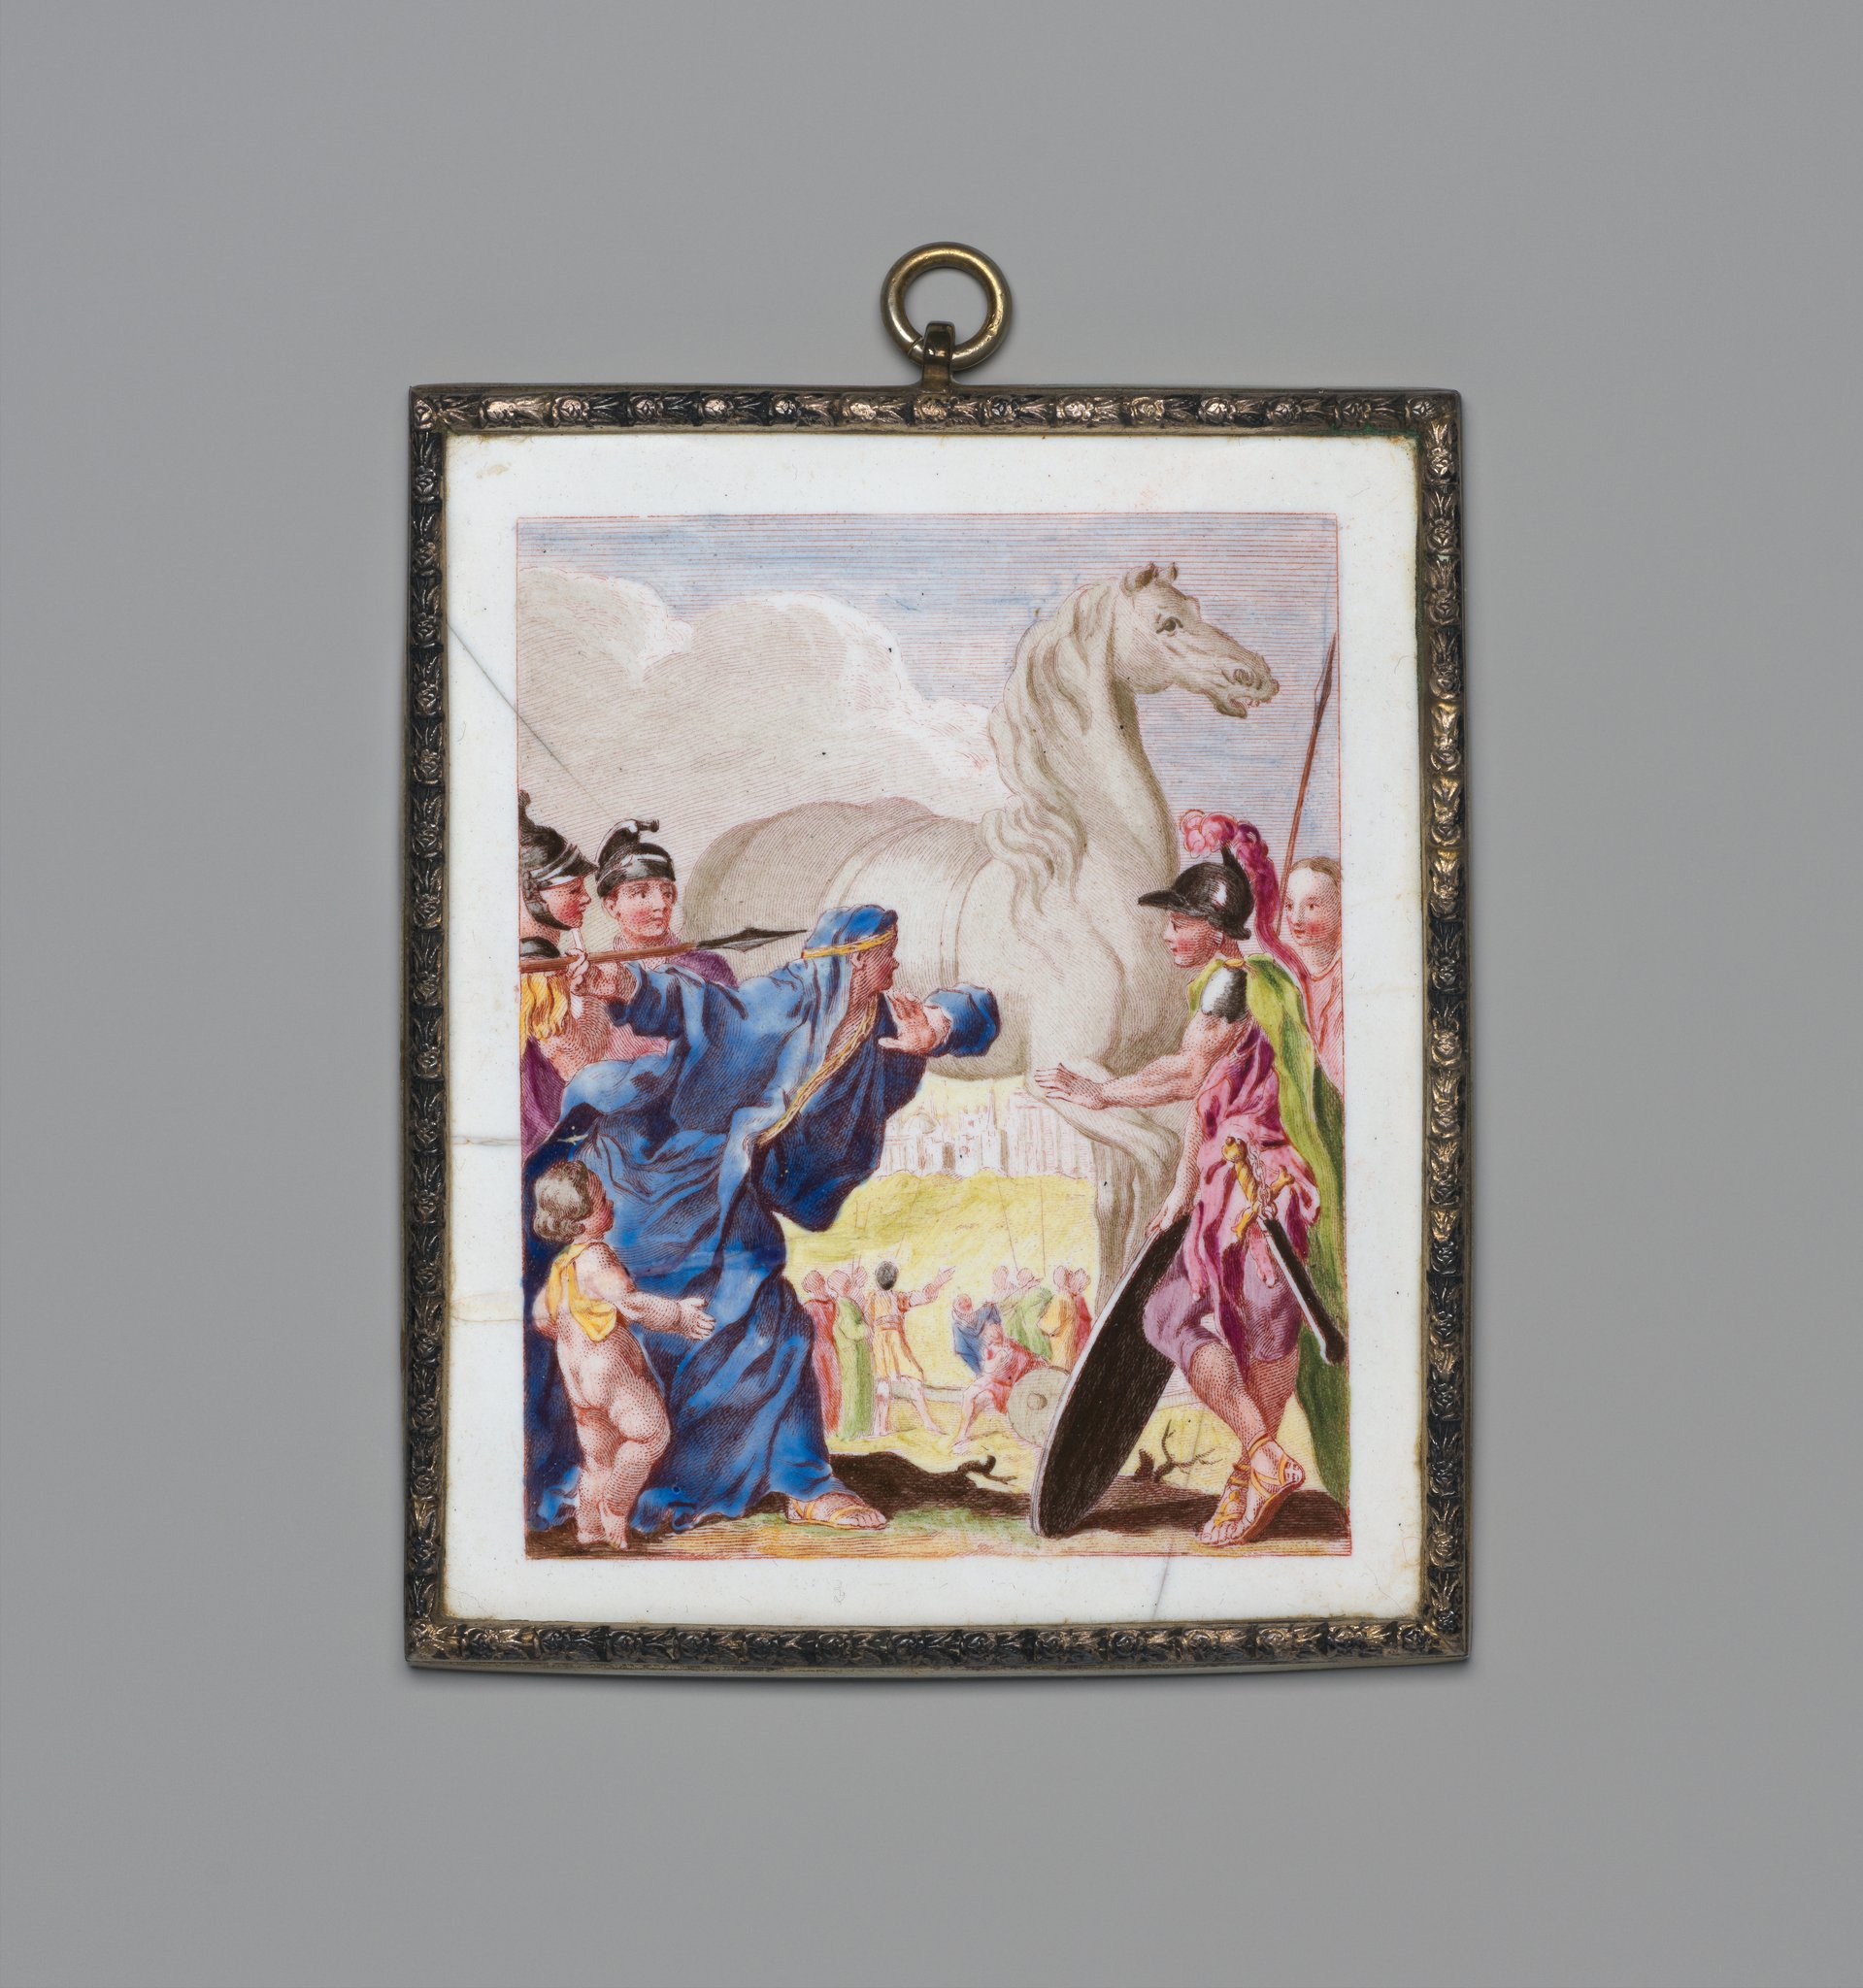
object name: plaque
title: Laocoon and the Trojan Horse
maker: simon francis ravenet, the elder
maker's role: artist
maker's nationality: french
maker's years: 1706-1774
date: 1753-1756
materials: copper, enamel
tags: horses